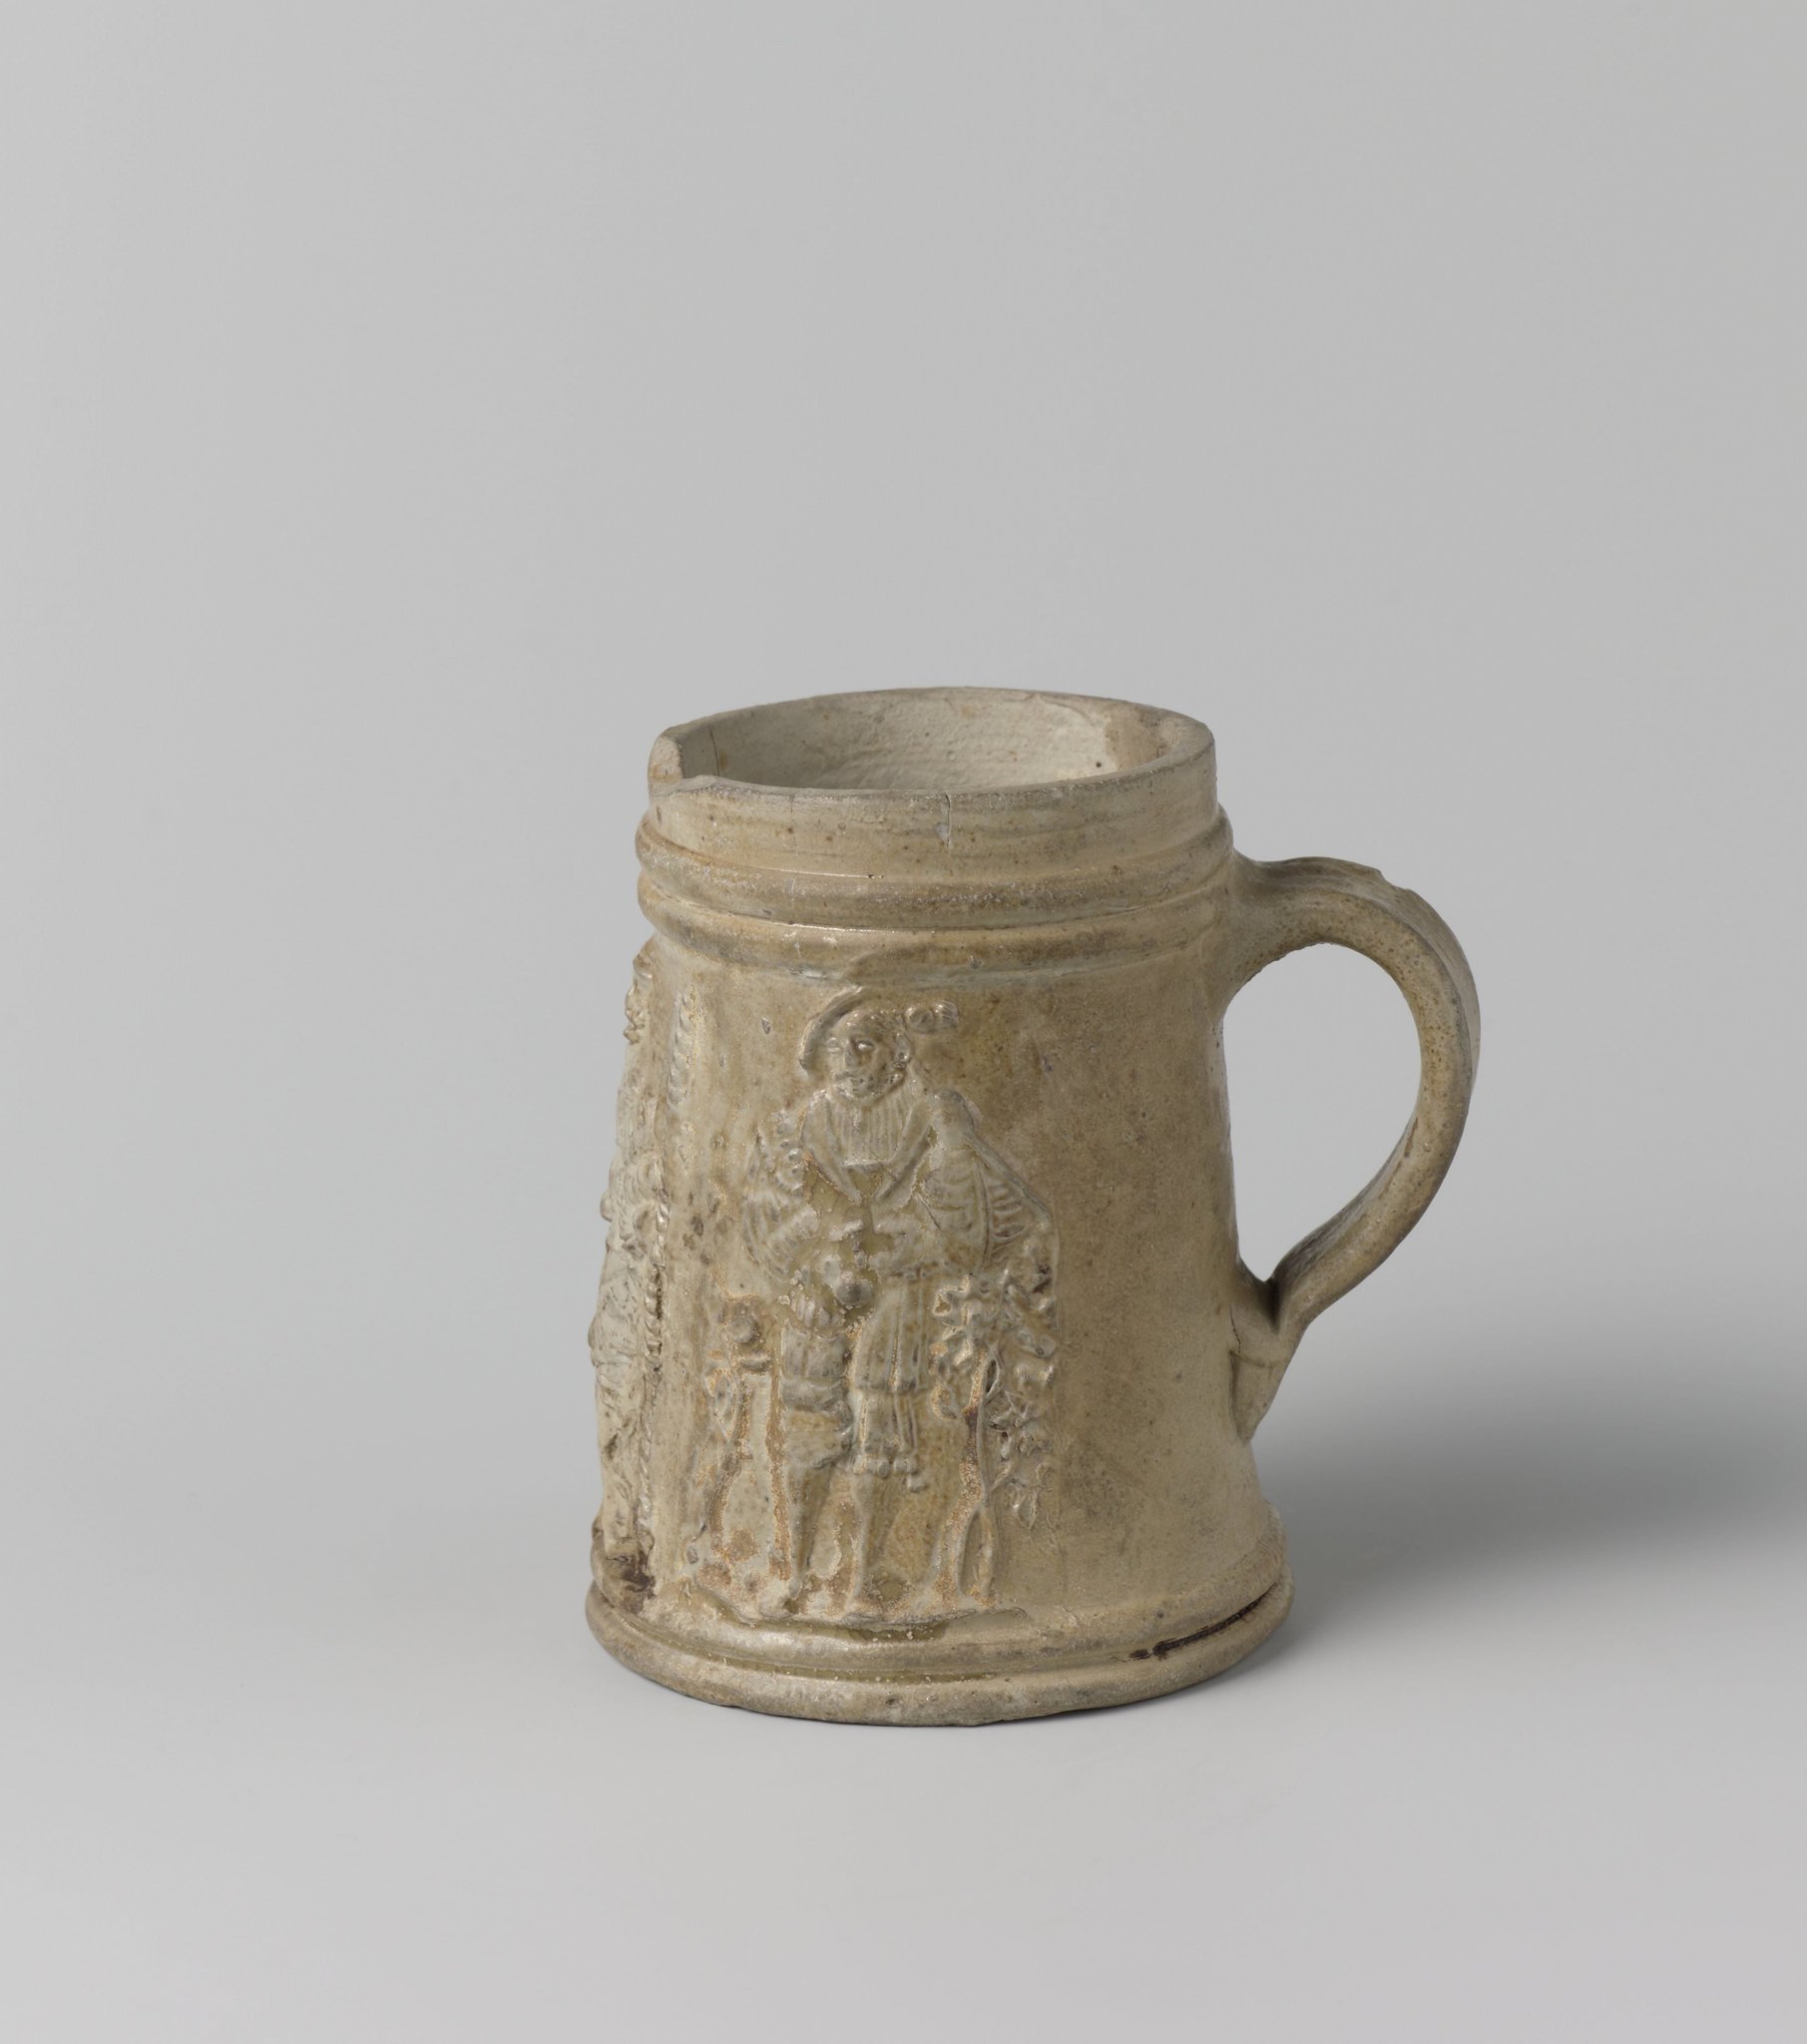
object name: stave tankard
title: Tankard with three men in relief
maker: Anonymous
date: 1540-1560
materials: glaze, stoneware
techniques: firing, forming, relief, turning, vitrification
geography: frechen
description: Bierpul van steengoed met een cilindrisch, iets taps toelopend lichaam, C-vormig oor en profielen op de rand en boven de voet. Op de pul in reliëf drie vakken met in elk een gedrukte en opgelegde decoratie van een man ten voeten uit, gekleed in 16e eeuwse kledij (krijgslieden?). Frechen/Keulen.